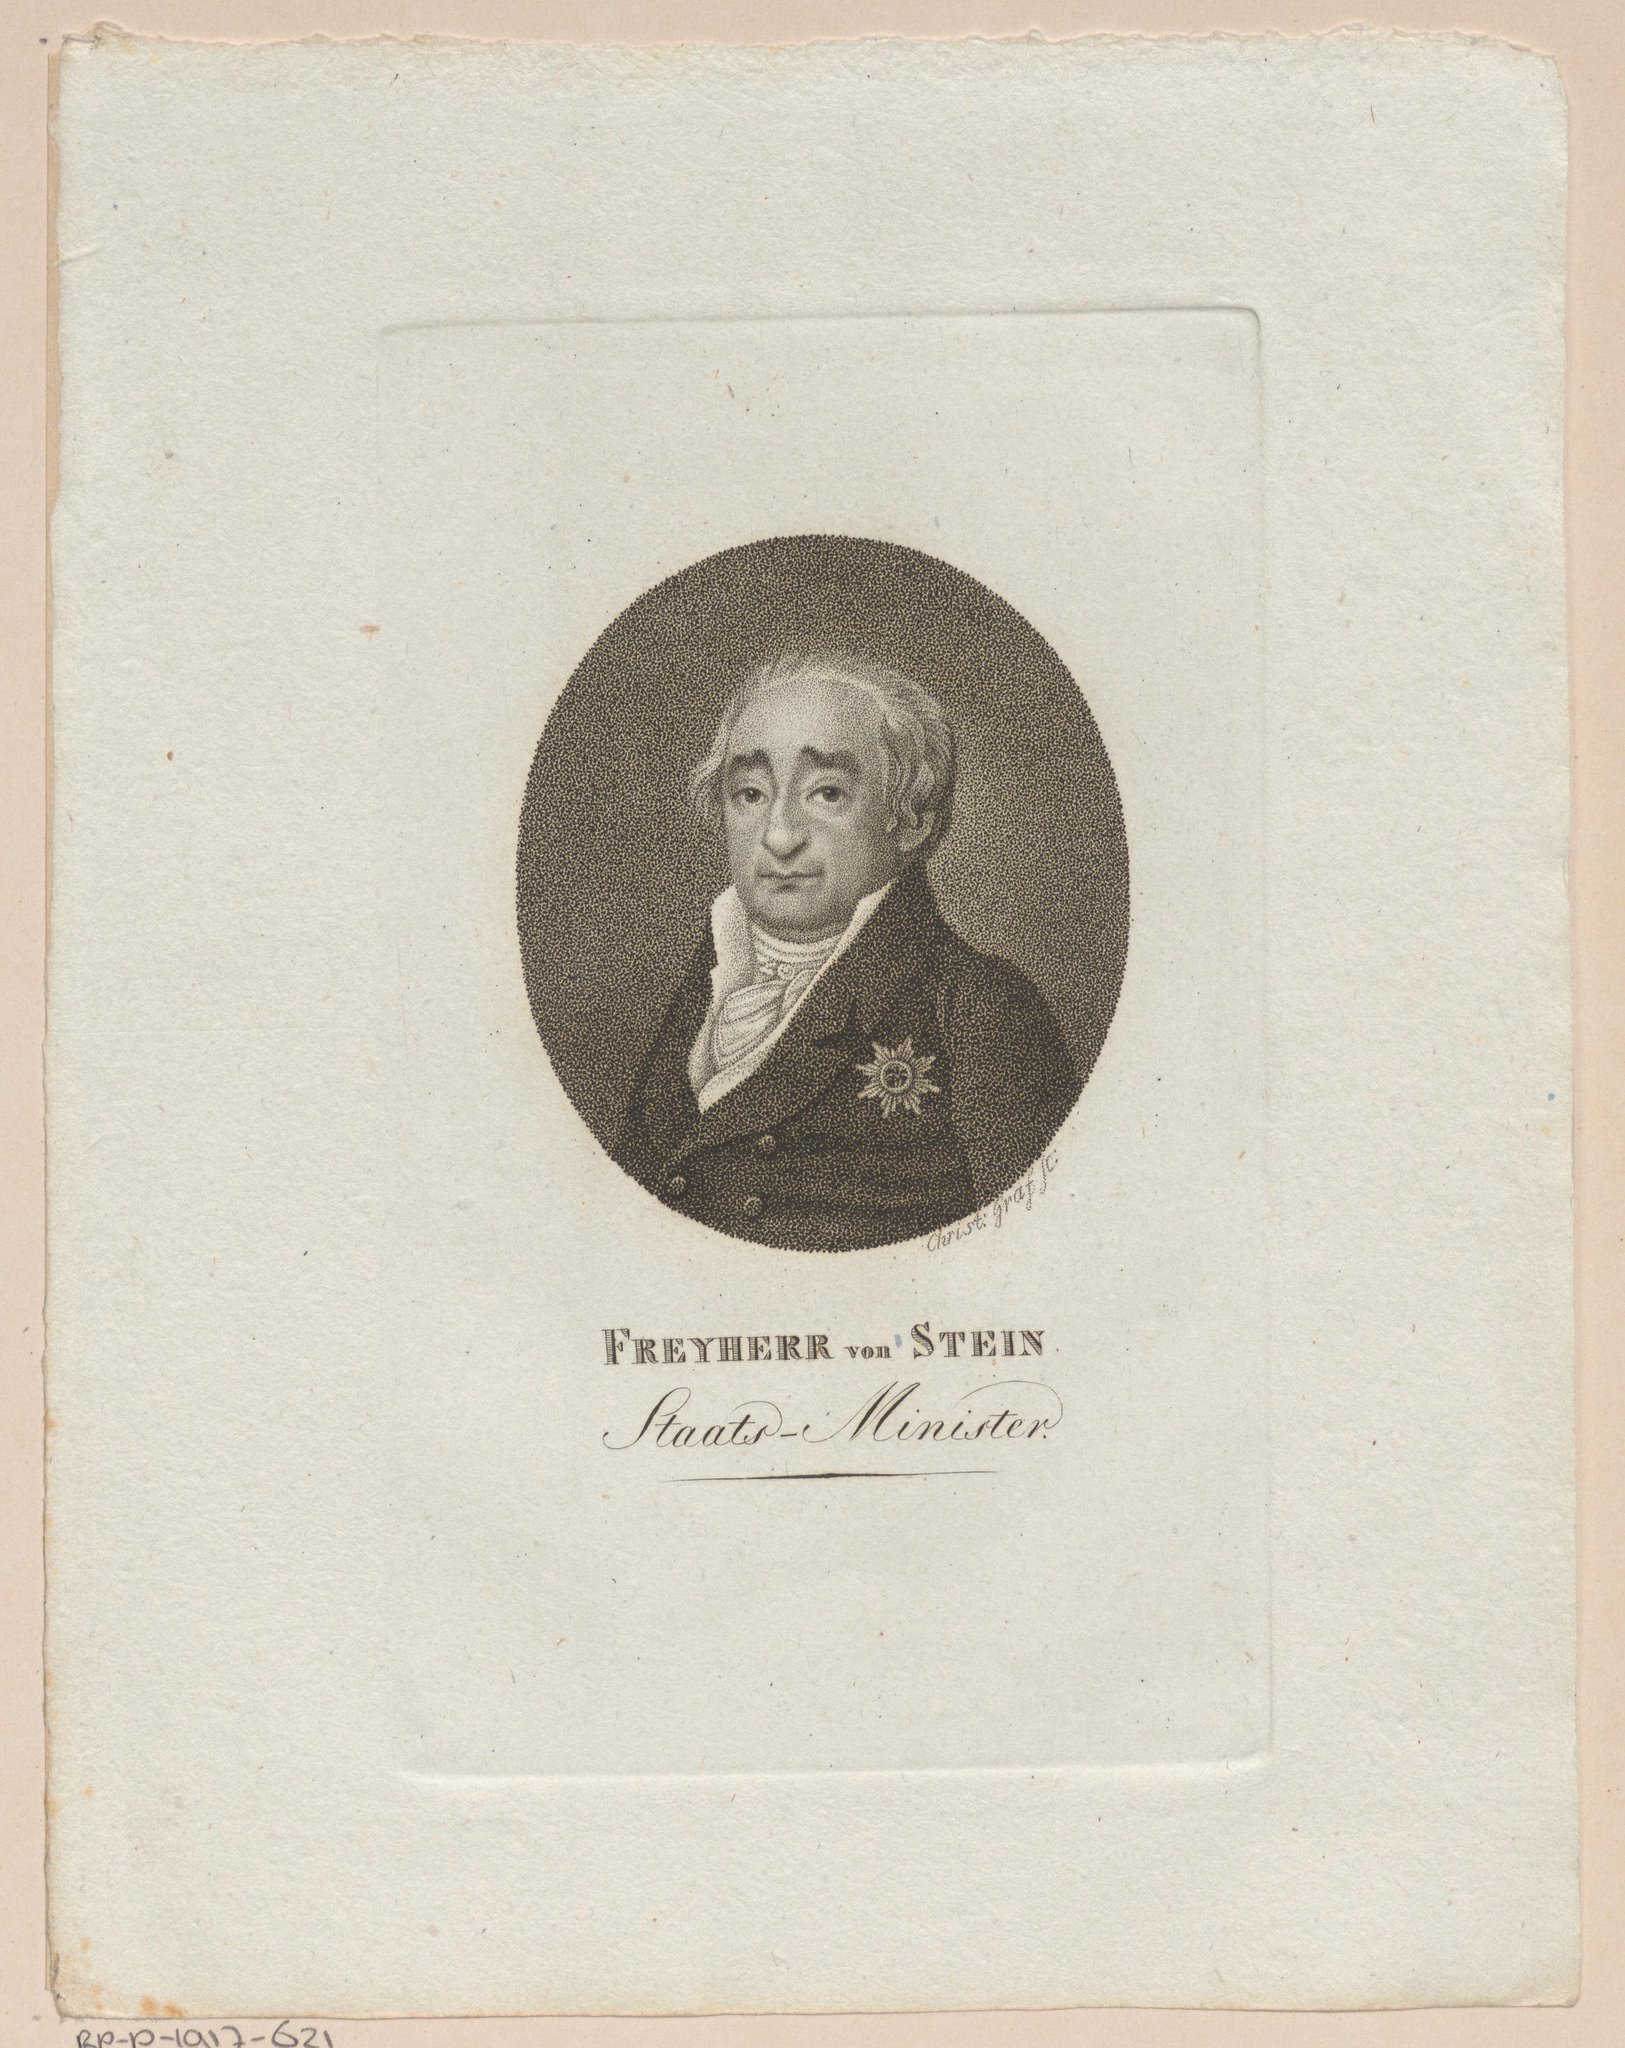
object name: print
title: Portret van Heinrich Friedrich Karl vom und zum Stein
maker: christ. graf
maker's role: print maker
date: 1804-1899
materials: paper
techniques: etching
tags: official; civil servant; functionary (in general), historical persons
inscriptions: collector's mark: Lugt 2228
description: Met eenregelig onderschrift in het Duits.